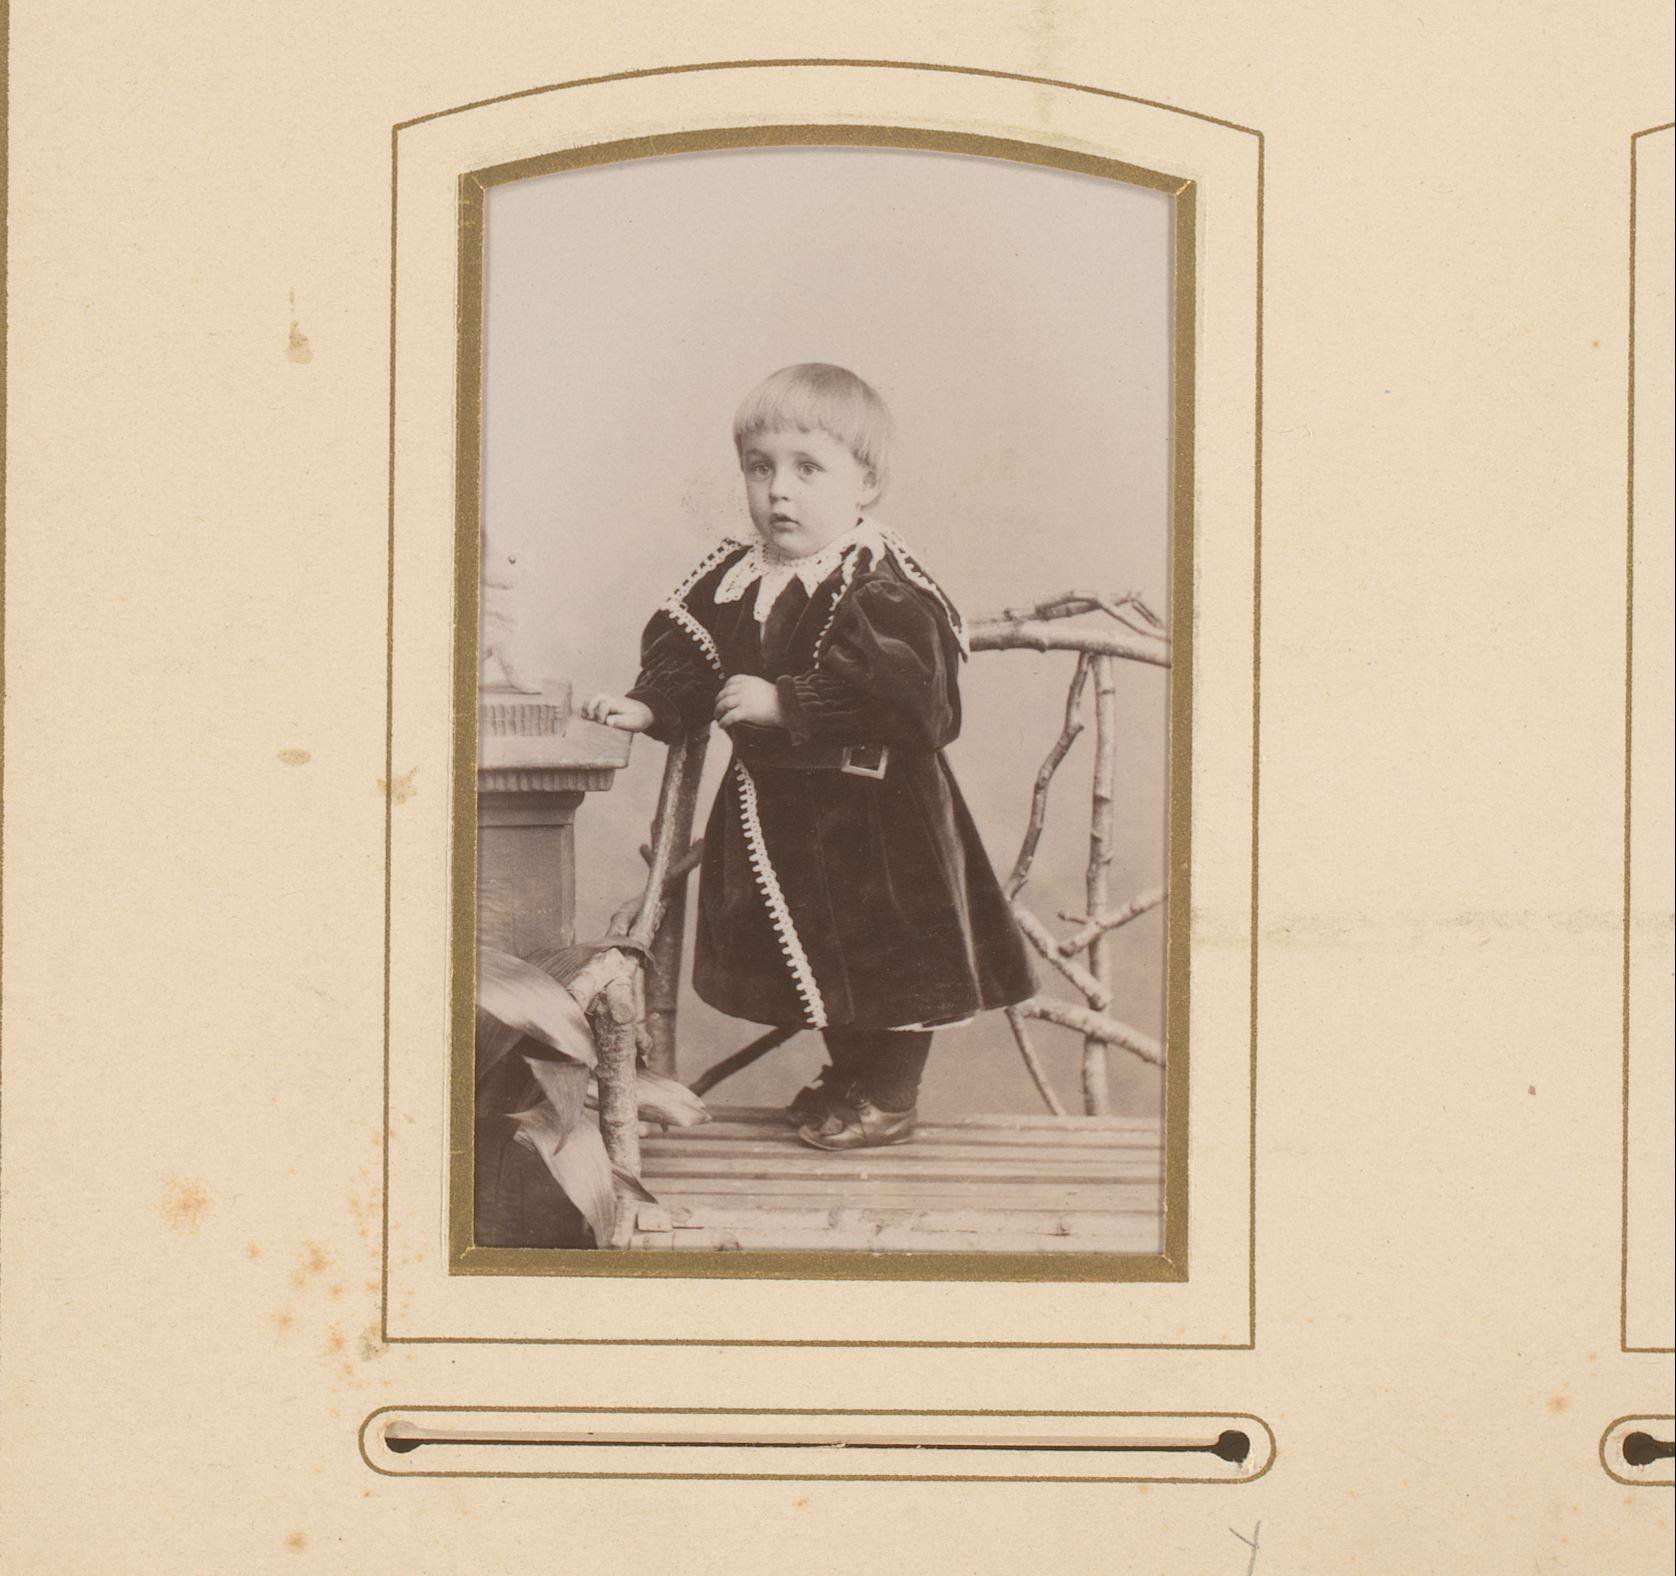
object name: album leaf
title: Portret van een peuter, staand op een stoel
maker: oscar strensch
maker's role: fotograaf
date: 1887-1900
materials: cardboard, photographic support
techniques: albumen print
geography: wittenberg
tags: historical persons, tot, toddler ~ the ages of man, chair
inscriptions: inscription: ‘(...)/ Oscar Strensch/ Hof-Photograph/ (...)/ Wittenberg/ Markt 14.’